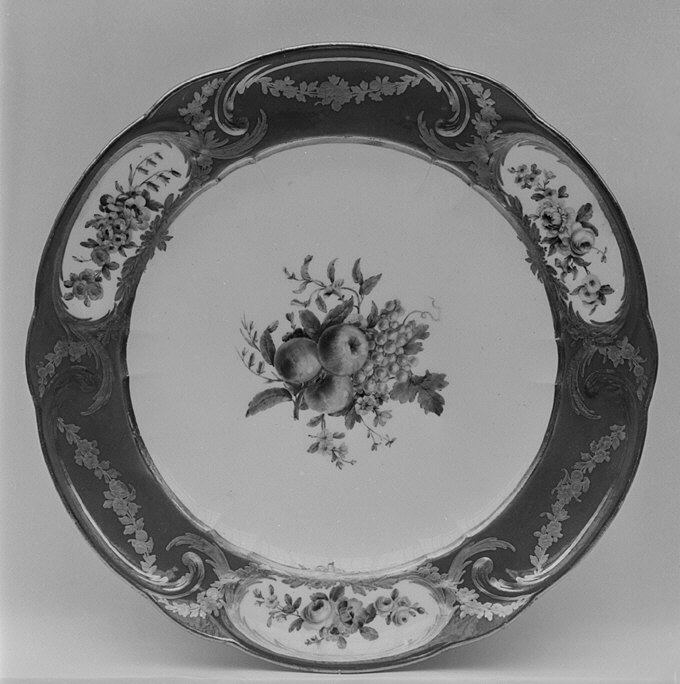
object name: plate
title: Plate (assiette à palmes) (1 of 102) (part of a service)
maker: sèvres manufactory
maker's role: manufactory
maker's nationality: french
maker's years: 1740-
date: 1777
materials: soft paste porcelain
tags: apples,grapes